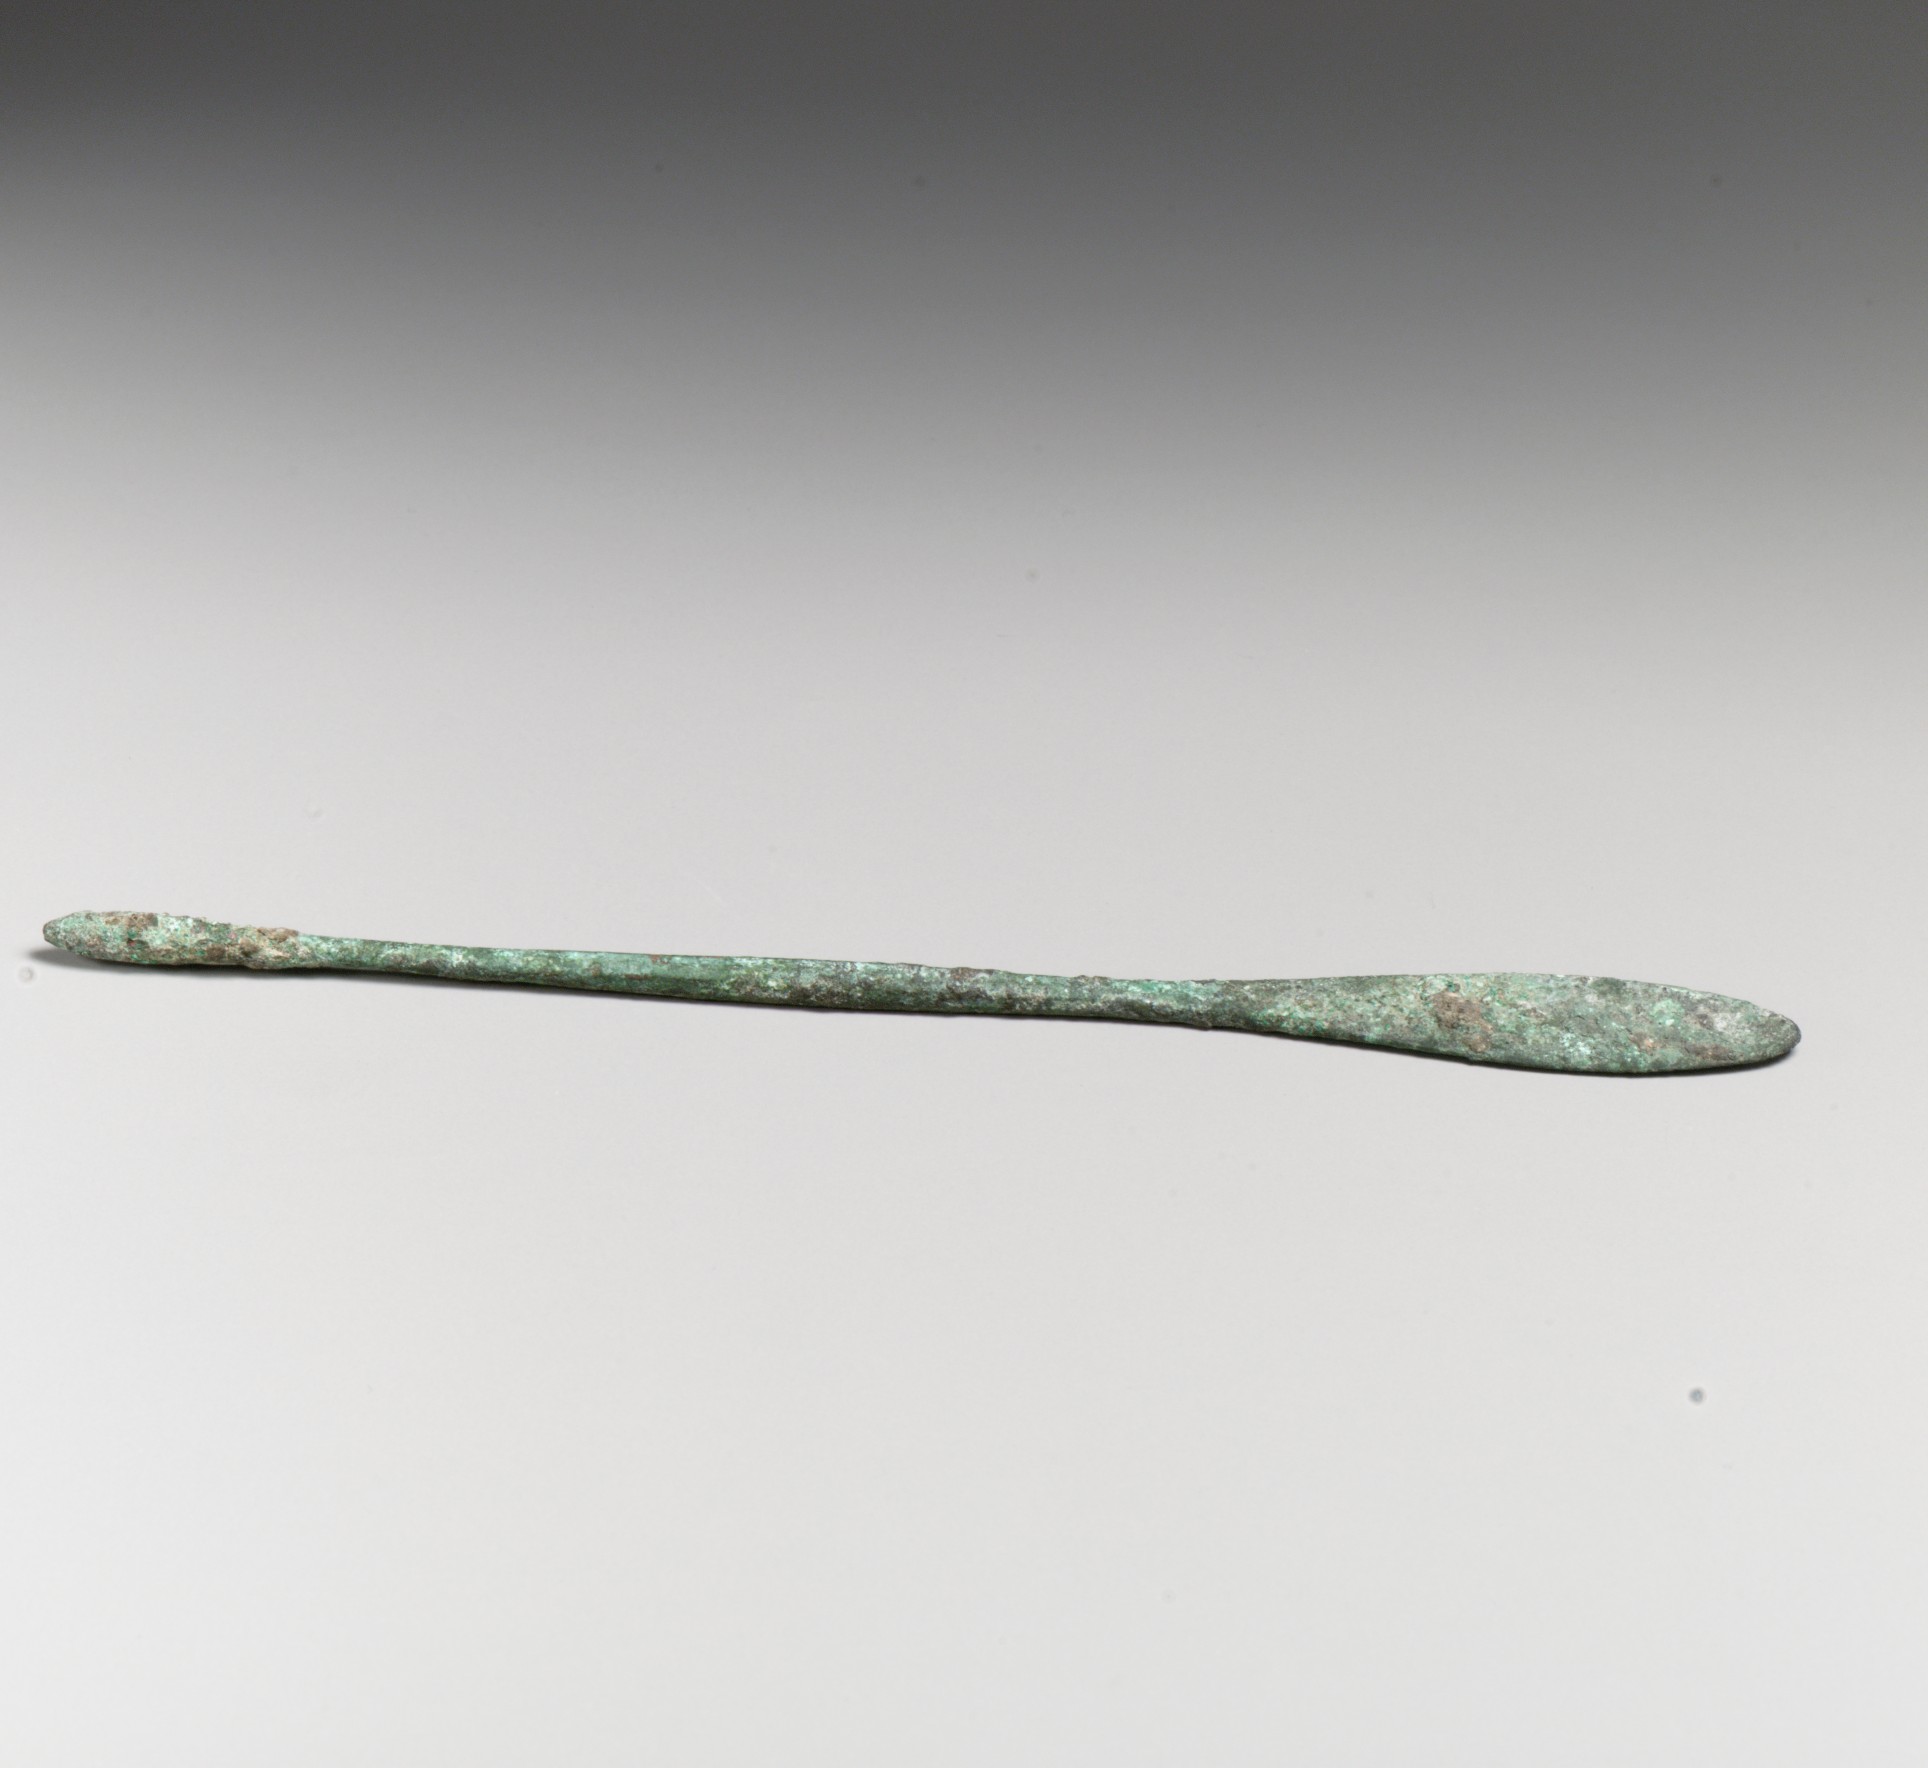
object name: spatula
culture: roman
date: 670 BCE-330 CE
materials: bronze